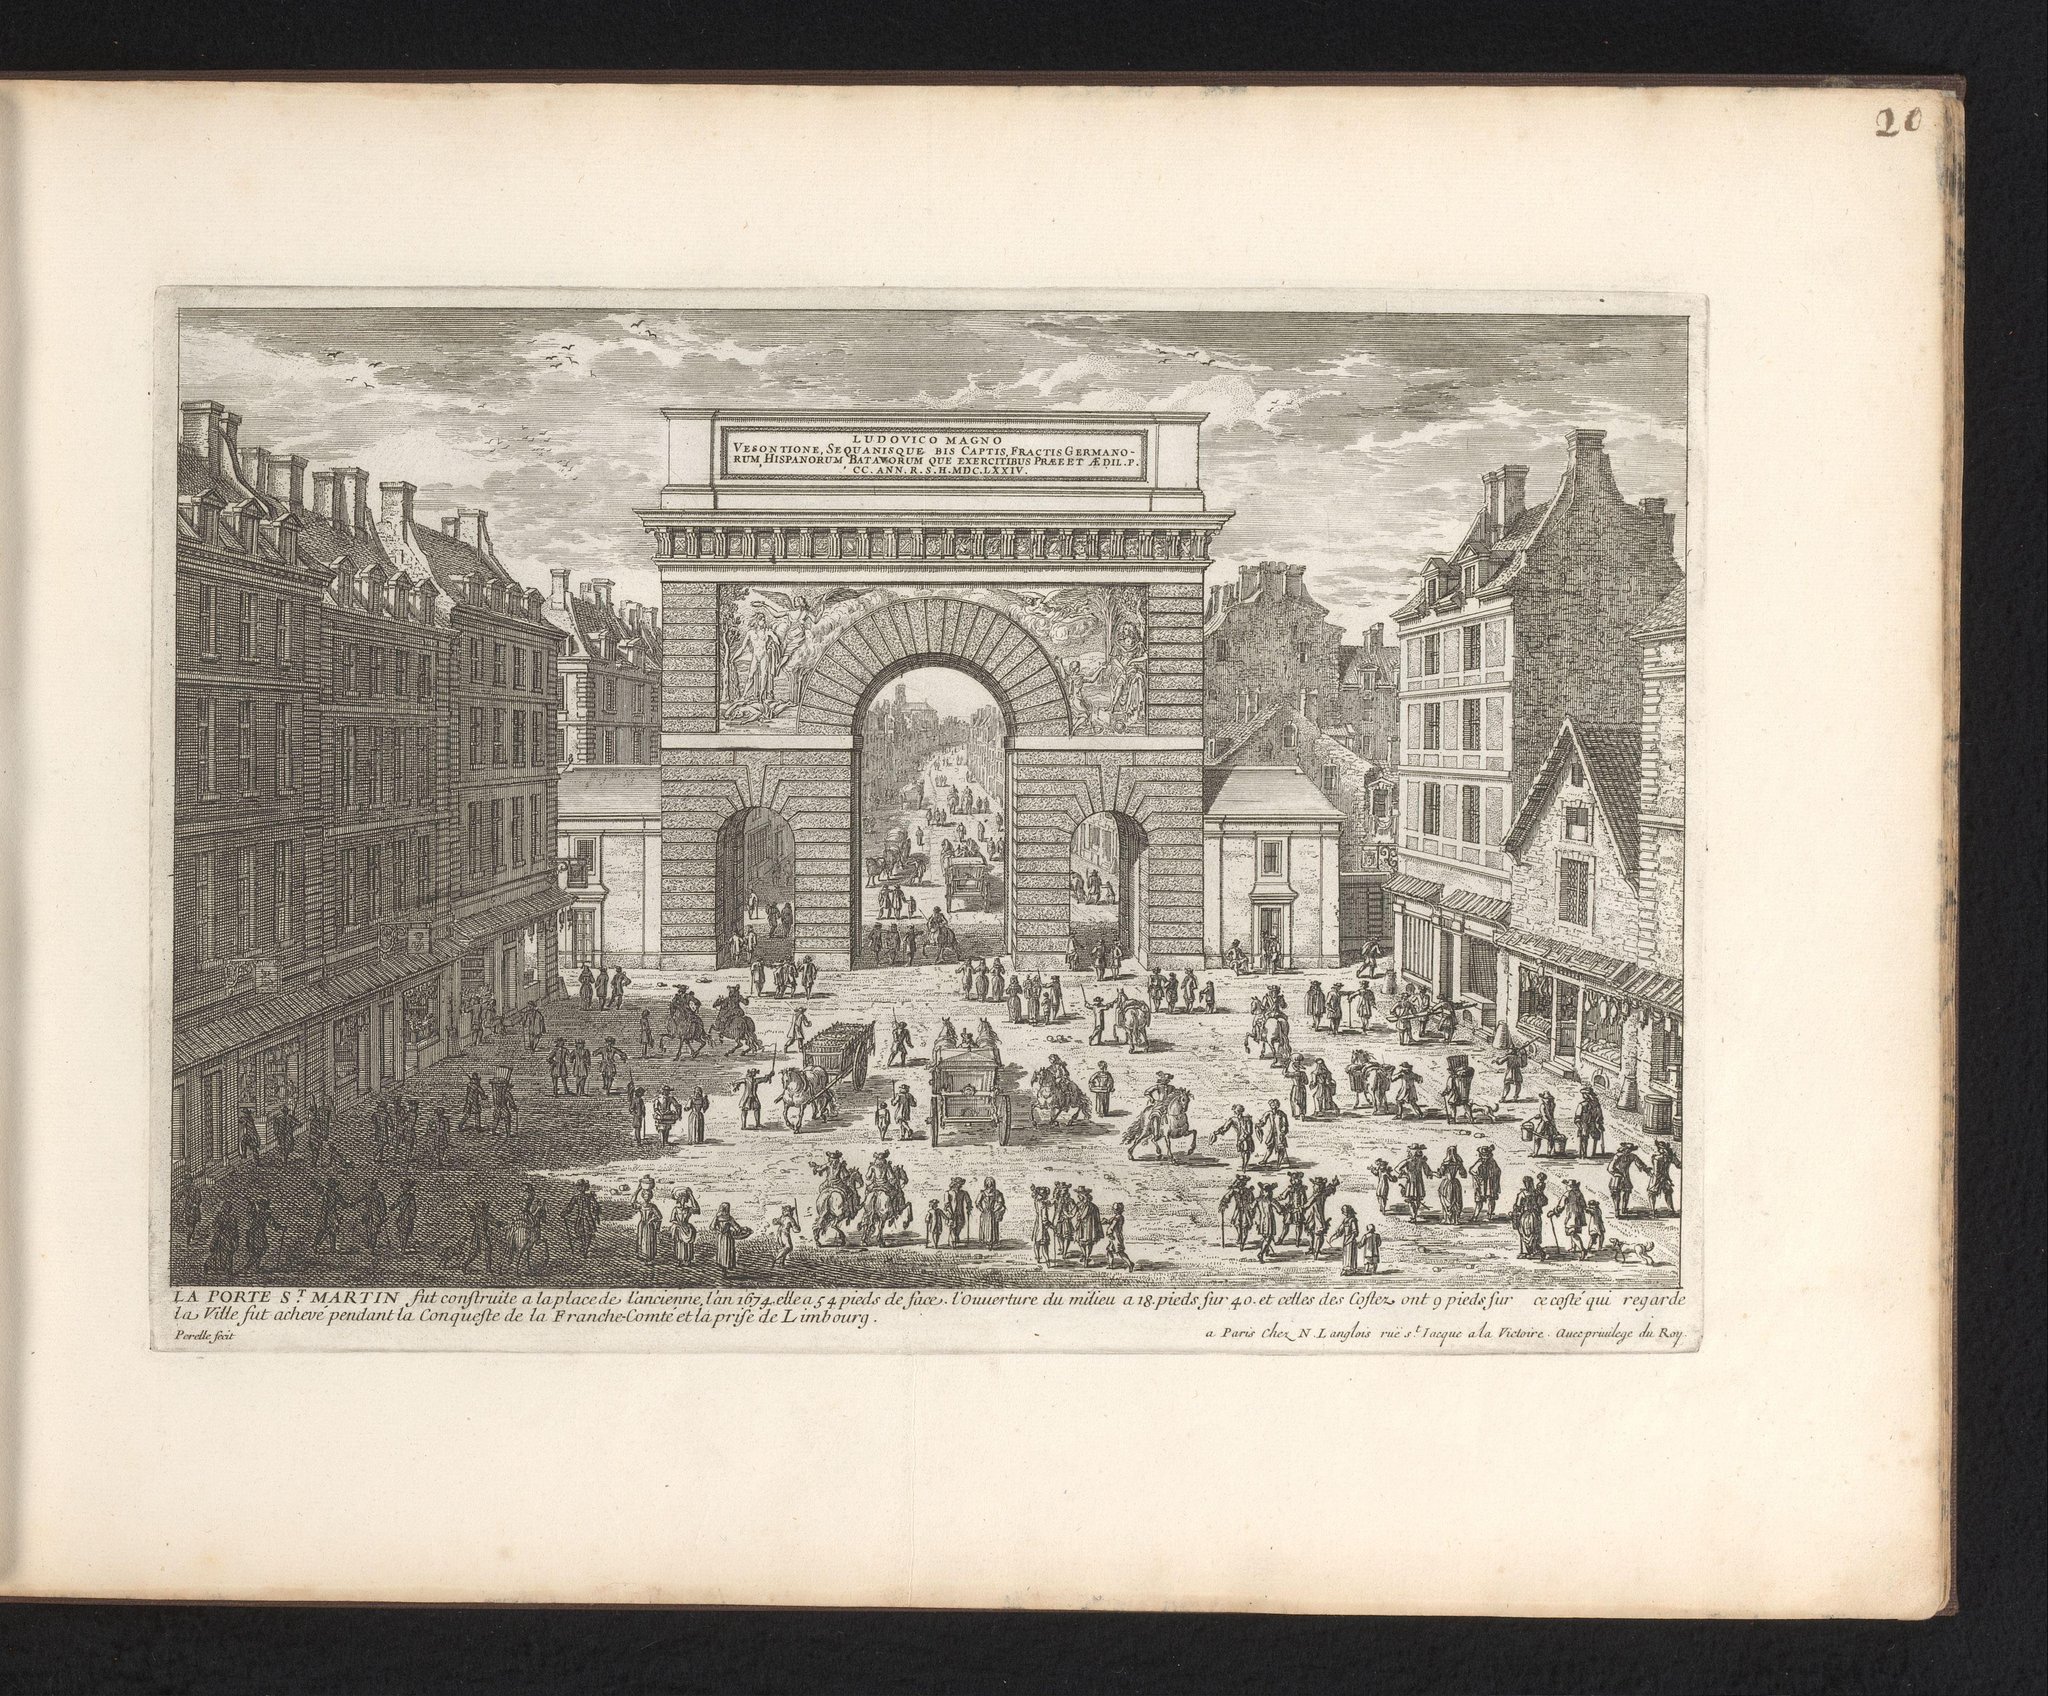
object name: album leaf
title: Stadsgezichten en landschappen in Frankrijk en Italië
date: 1673-1695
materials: paper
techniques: etching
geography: paris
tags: city-gate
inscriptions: collector's mark: Lugt 2228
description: Prenten met het signatuur 'Perelle' kunnen zowel door vader Gabriel als door zonen Nicolas en Adam gemaakt zijn. De uitgevers vader en zoon Nicolas Langlois worden allebei vermeld als N. Langlois op hetzelfde adres.